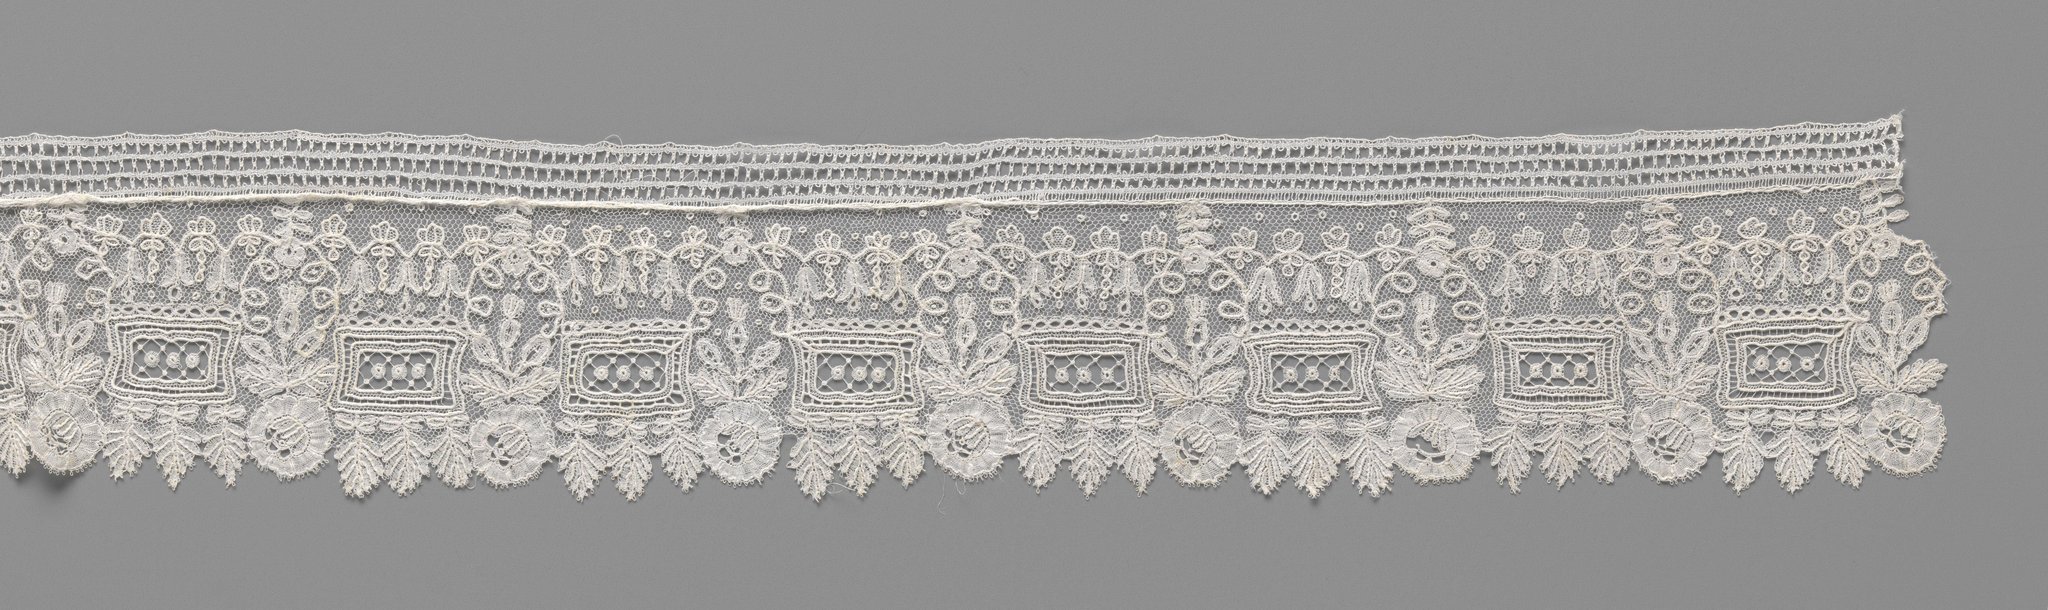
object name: strip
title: Strook gemengde kant met liggende rechthoeken tussen hangende rozen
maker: Anonymous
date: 1865-1880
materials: linen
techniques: lace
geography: brussels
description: Strook naturelkleurige gemengde kant: point d'Angleterre. Het zich herhalende patroon bestaat uit liggende rechthoeken. Boven de rechthoeken loopt in een rechte lijn een aaneenschakeling van boogjes. Tussen de rechthoeken hangt een groter boogje met een hangende roos eronder, die tot aan de onderzijde van de strook reikt en daar een schulp vormt. De schulpenrand wordt aangevuld door de drie blaadjes die steeds onder elke rechthoek naar beneden hangen. Een deel van de motieven, zoals de hangende rozen en de blaadjes onder de rechthoeken, is gemaakt in linnenslag met opengewerkte randjes en glimmende contourdraden. Verschillende motieven worden geaccentueerd door reliëfcontouren. Een ander deel, zoals de rechthoeken en kleine motiefjes op de boogjes zijn gemaakt in naaldkant. De motieven zijn met elkaar verbonden door een fijne maasgrond, een gaaskantgrond. De bovenzijde van de strook is recht afgewerkt met een apart geklost breed bandje. De schulpenrand is afgewerkt met picots.